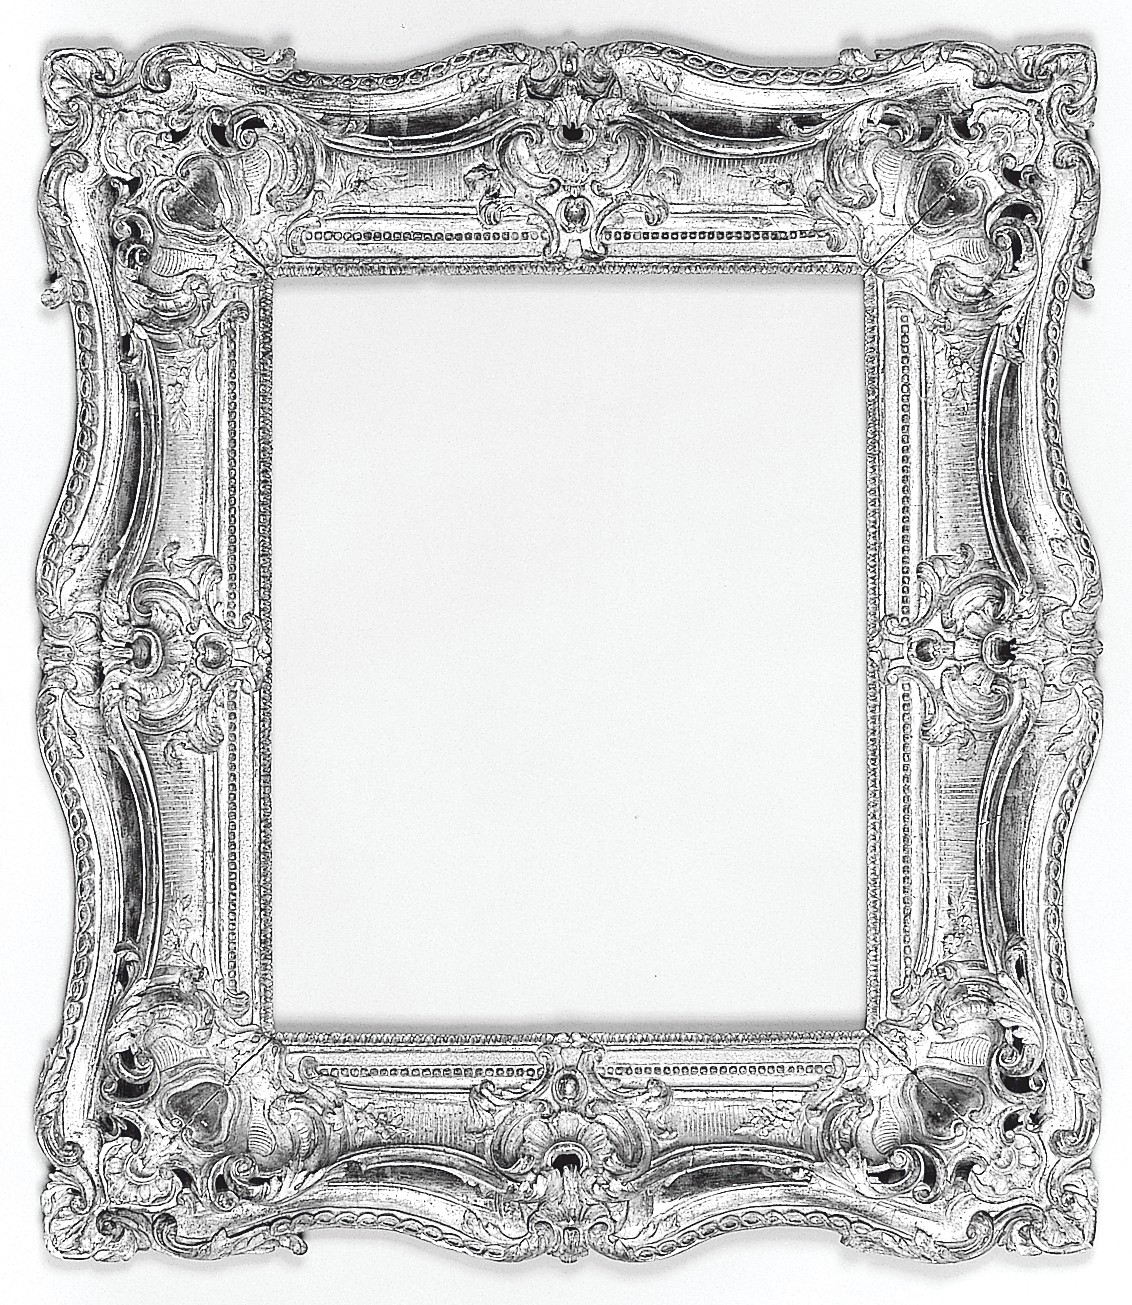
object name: frame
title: Swept frame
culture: french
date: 1870-1900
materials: wood